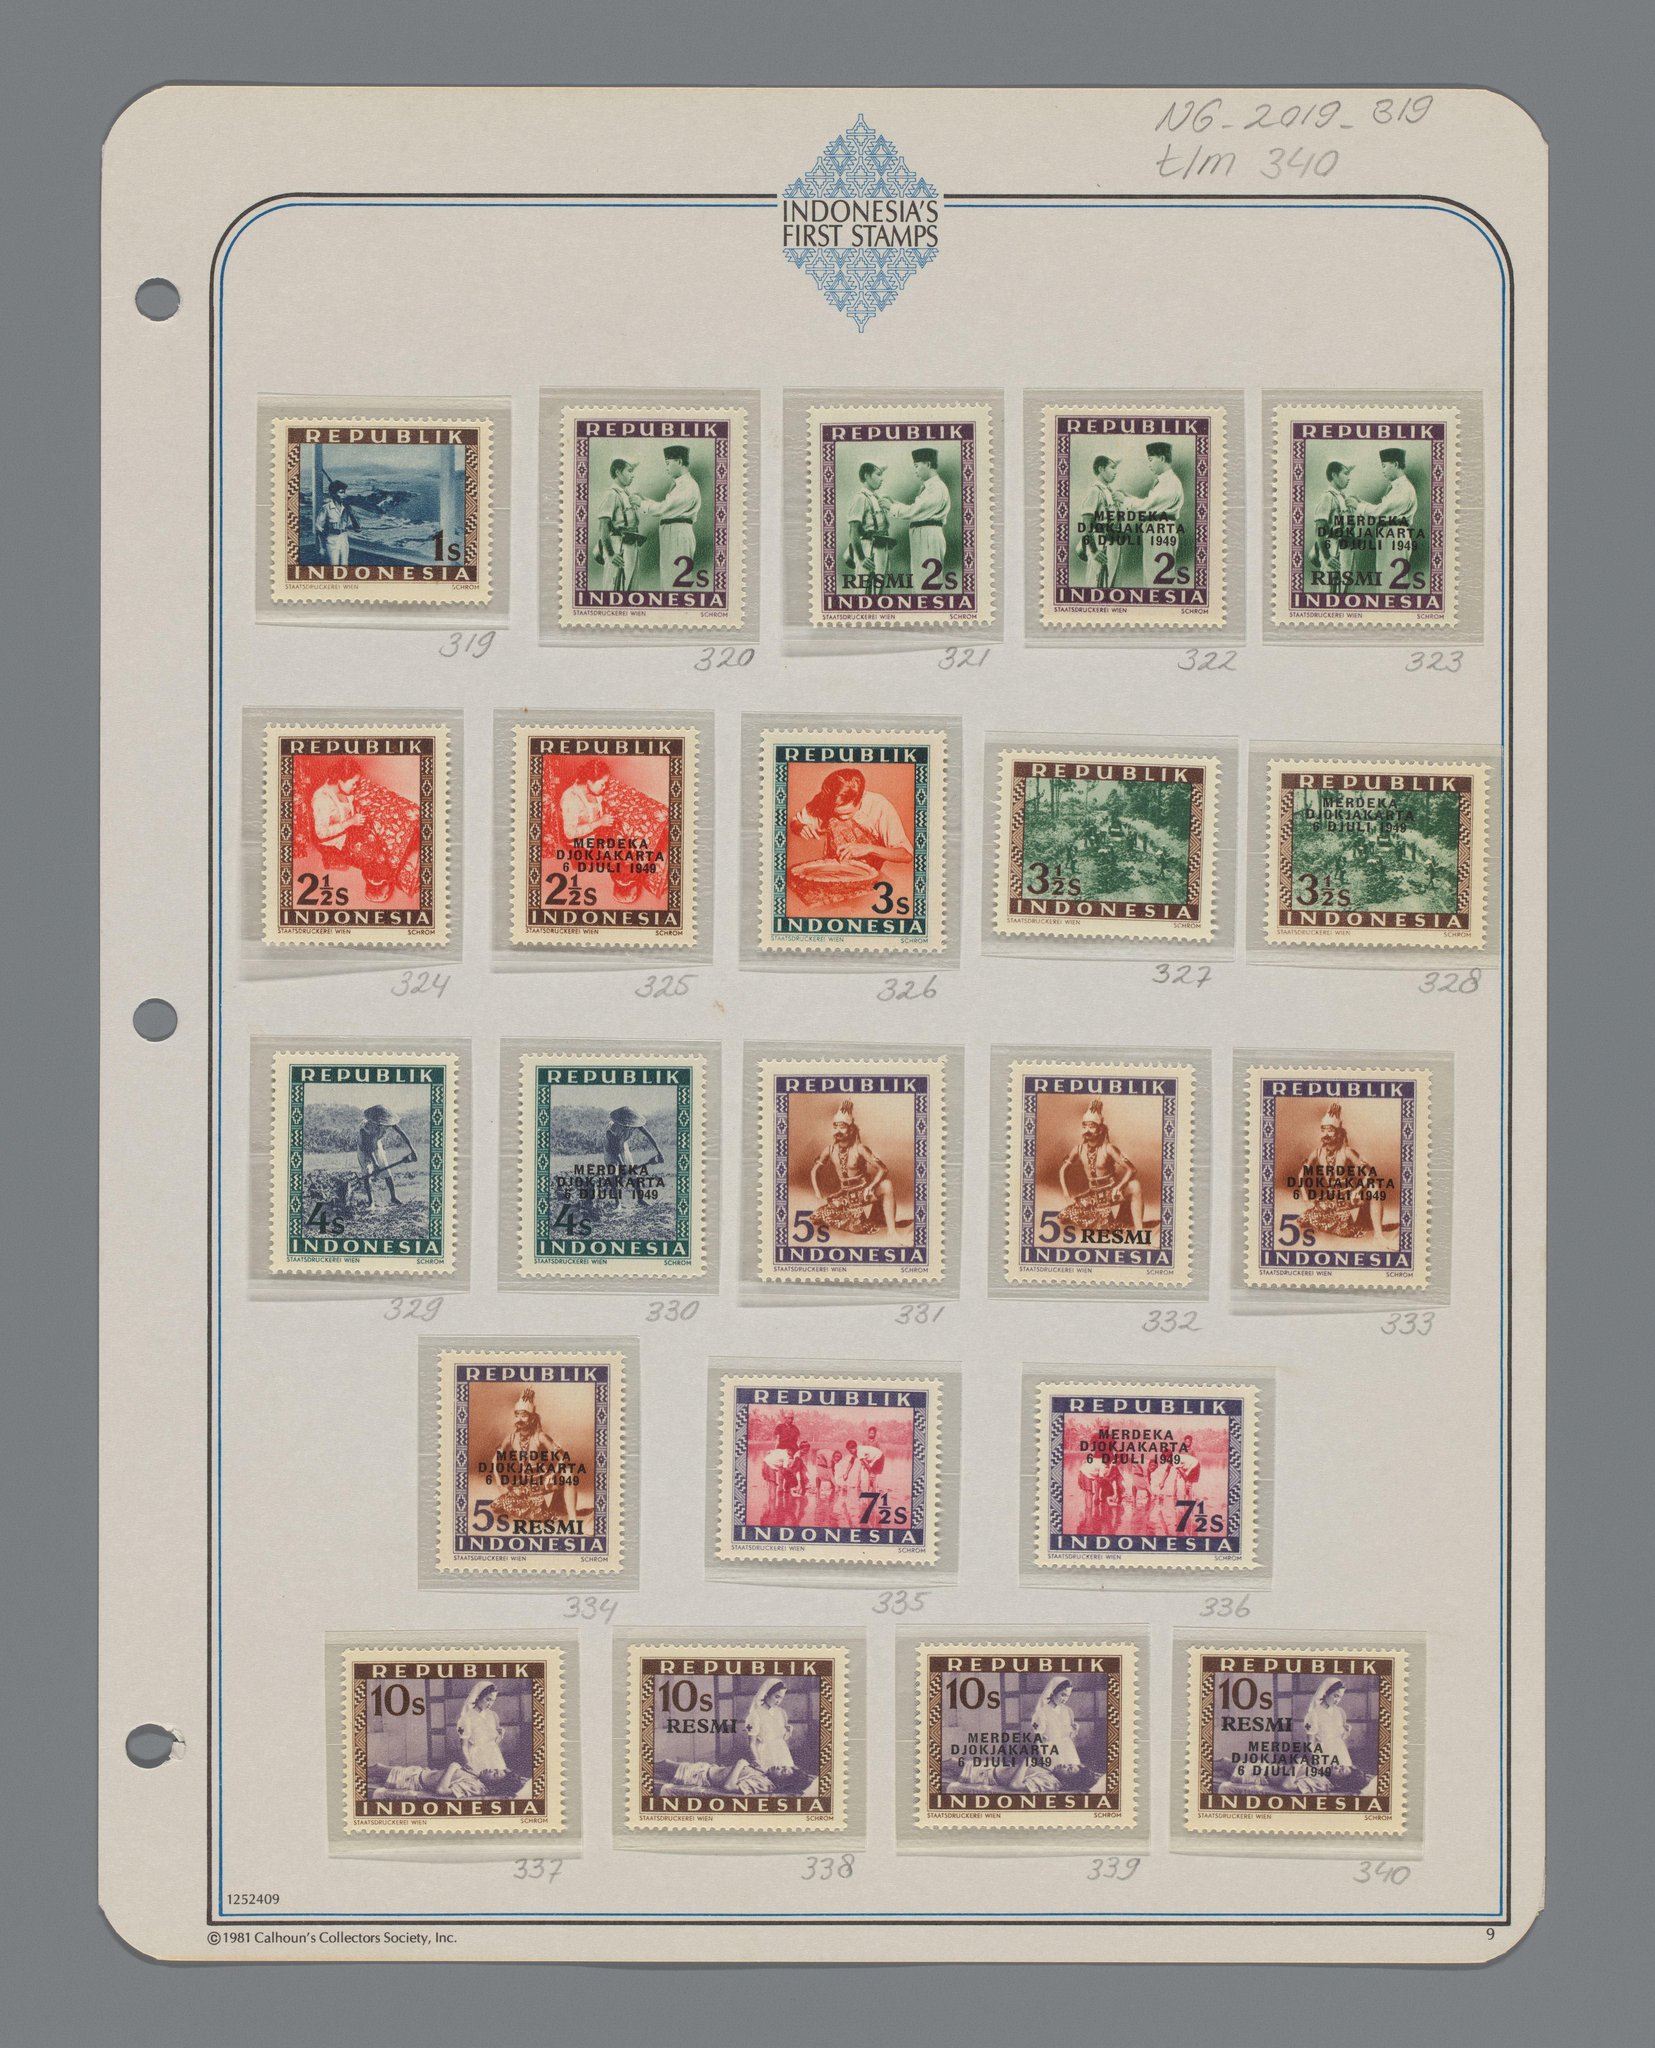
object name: postage stamp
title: Postzegel Republik Indonesia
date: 1949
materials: paper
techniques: photoaquatint, engraving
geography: philadelphia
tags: indonesia